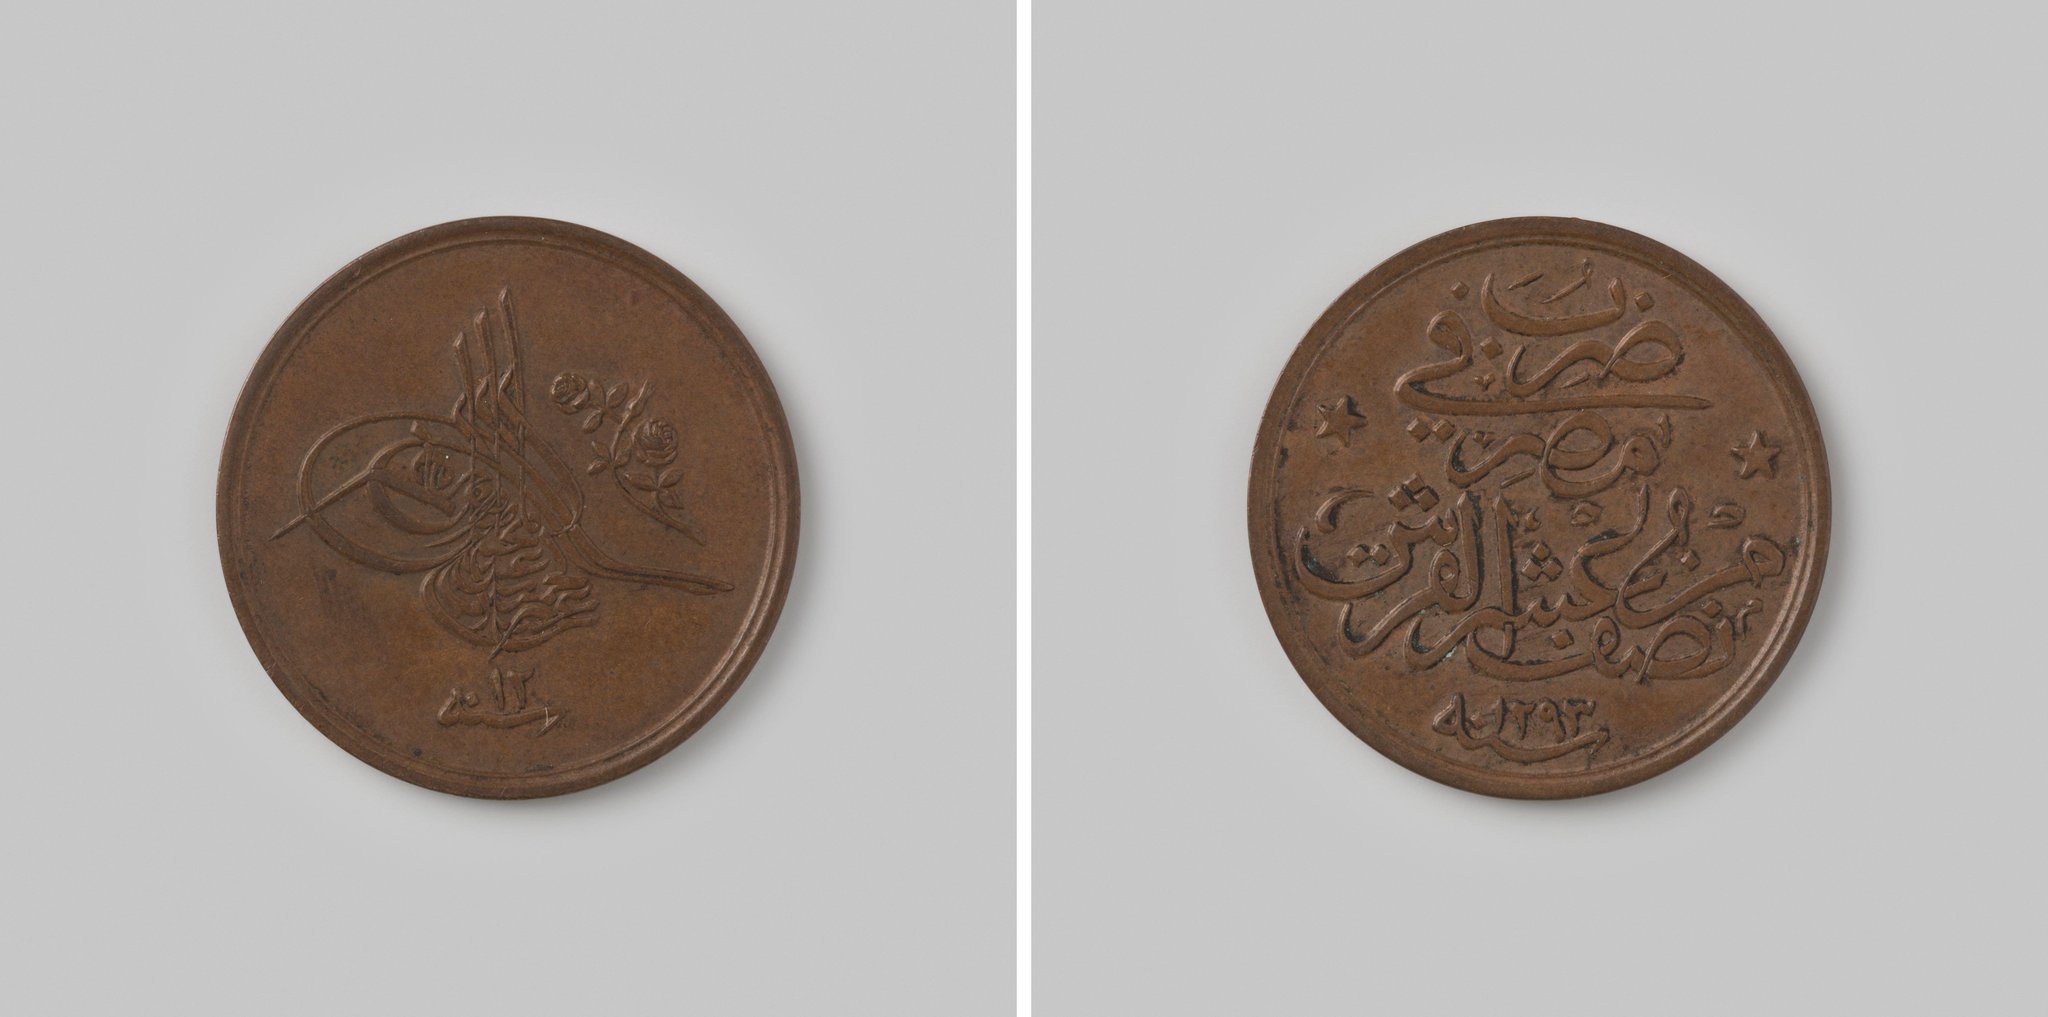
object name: coin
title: 1/20 qirsh uit Egypte van de Ottomaanse sultan Abdul Hamid II, regeringsjaar 12 [=1886]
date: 1886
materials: bronze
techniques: striking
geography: cairo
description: Bronzen munt. Voorzijde: tughra met rechts daarvan takje met bladeren. Onder de tughra in twee regels het regeringsjaar: 12. Keerzijde: vijfregelig opschrift in Arabische letters met muntplaats-aanduiding: Misr [=Egypte] en waarde-aanduiding. Onder waarde-aanduiding jaar van aantreden:1293 [=1875]. Kartelrand.